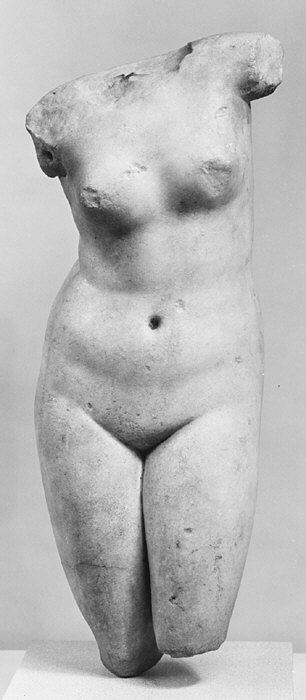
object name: statuette of aphrodite anadyomene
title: Marble statuette of Aphrodite Anadyomene (rising)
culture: greek or roman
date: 200-201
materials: marble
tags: female nudes,aphrodite